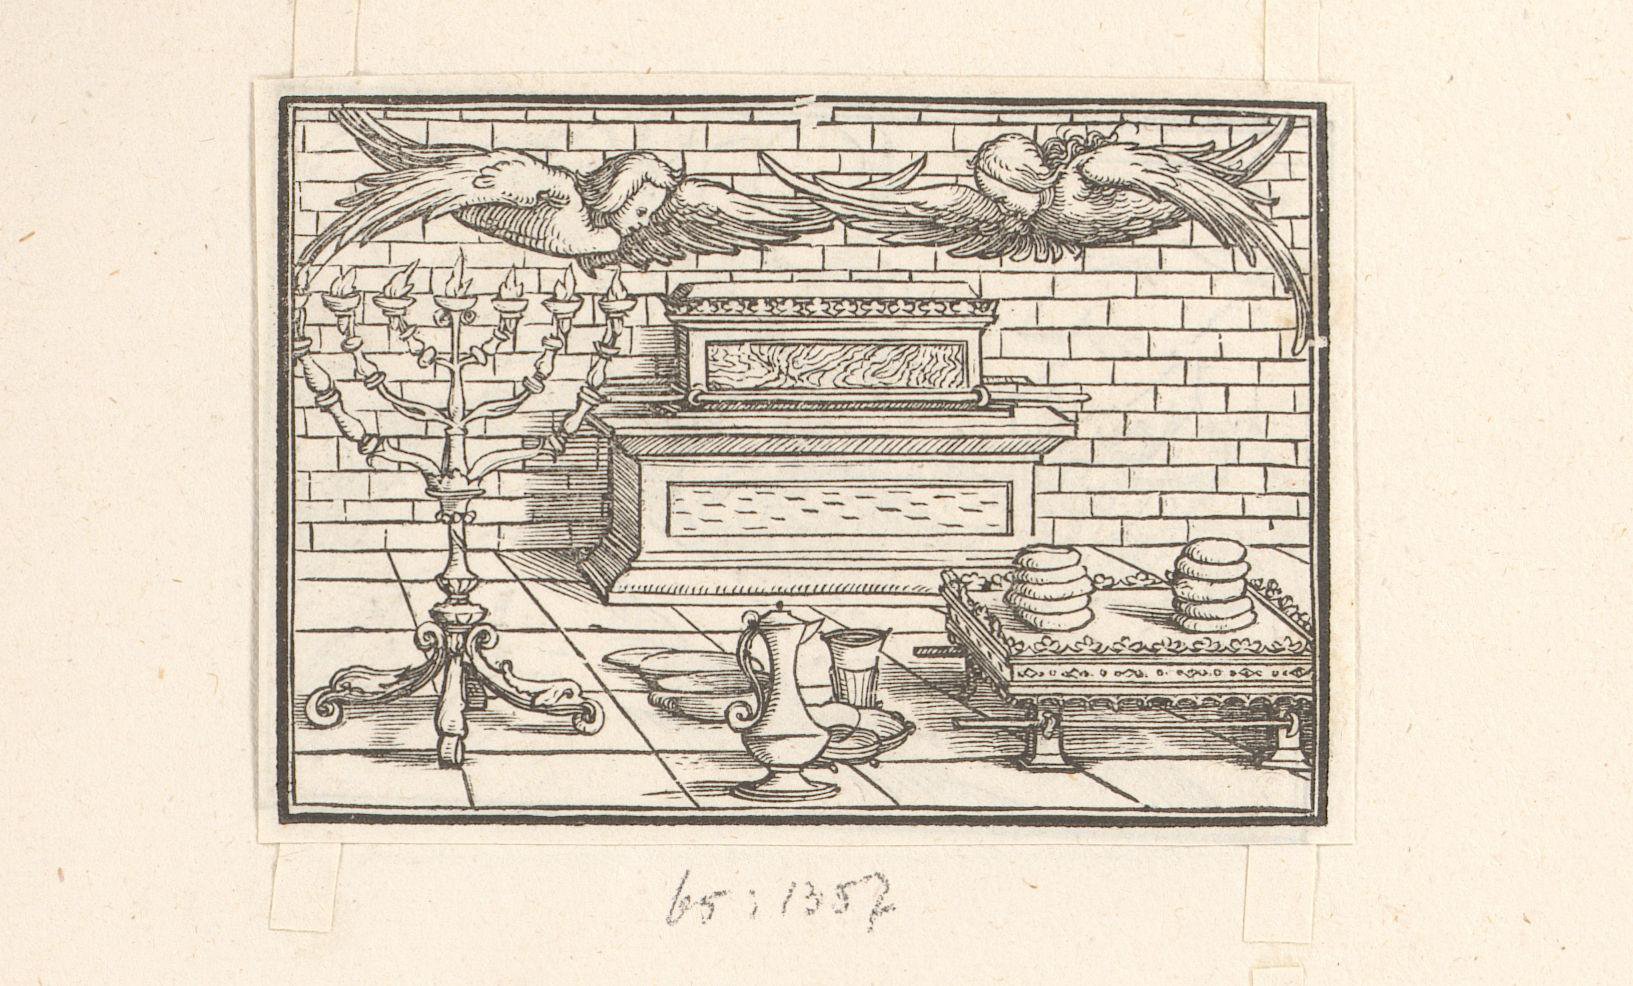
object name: print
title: Ark van het verbond en voorwerpen uit de tabernakel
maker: veit rudolf specklin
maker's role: print maker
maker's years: -1550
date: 1538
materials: paper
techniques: woodcut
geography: switzerland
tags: other objects kept in the tabernacle, ark of the covenant ~ jewish religion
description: Boekillustratie voor het eerst gebruikt in: Biblia Utriusque Testamenti iuxta Vulgatam Translationem, Lyon, M. en G. Trechsel (voor Hugo à Porta) 1538. Later in verschillende uitgaven opnieuw gebruikt. Deze prent vermoedelijk gebruikt in één van de uitgaven uitgegeven en/of gedrukt door Jean Frellon, Lyon.